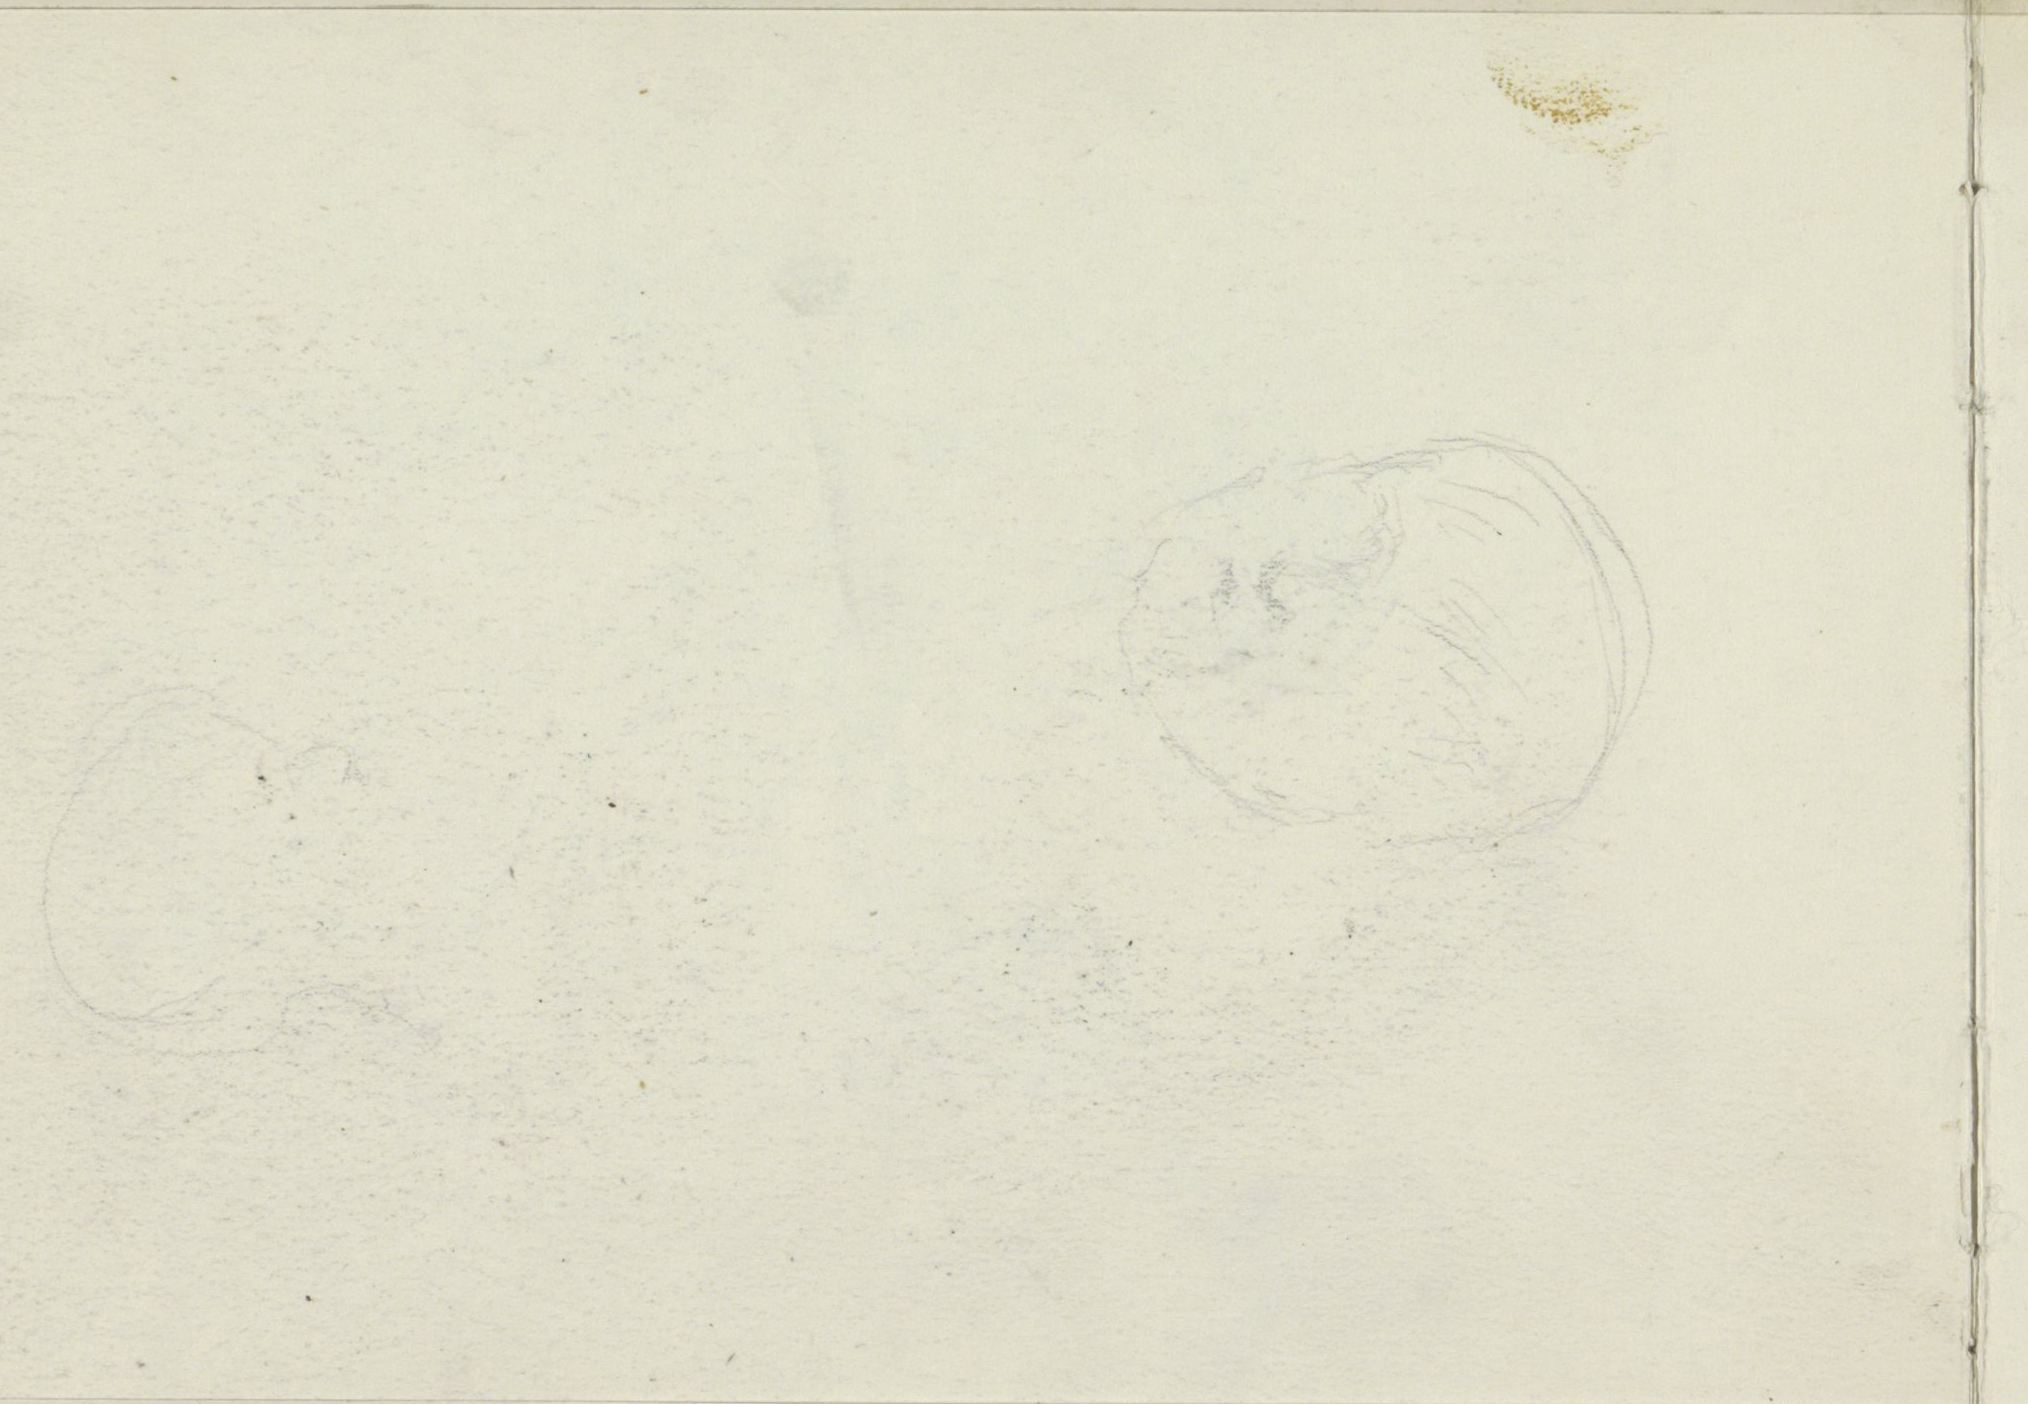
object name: sketchbook leaf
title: Kop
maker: jozef israëls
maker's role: draughtsman, painter, print maker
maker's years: 1824-1911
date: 1885-1902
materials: paper, pencil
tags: head (human)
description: Blad 15 verso uit een schetsboek met 17 bladen.